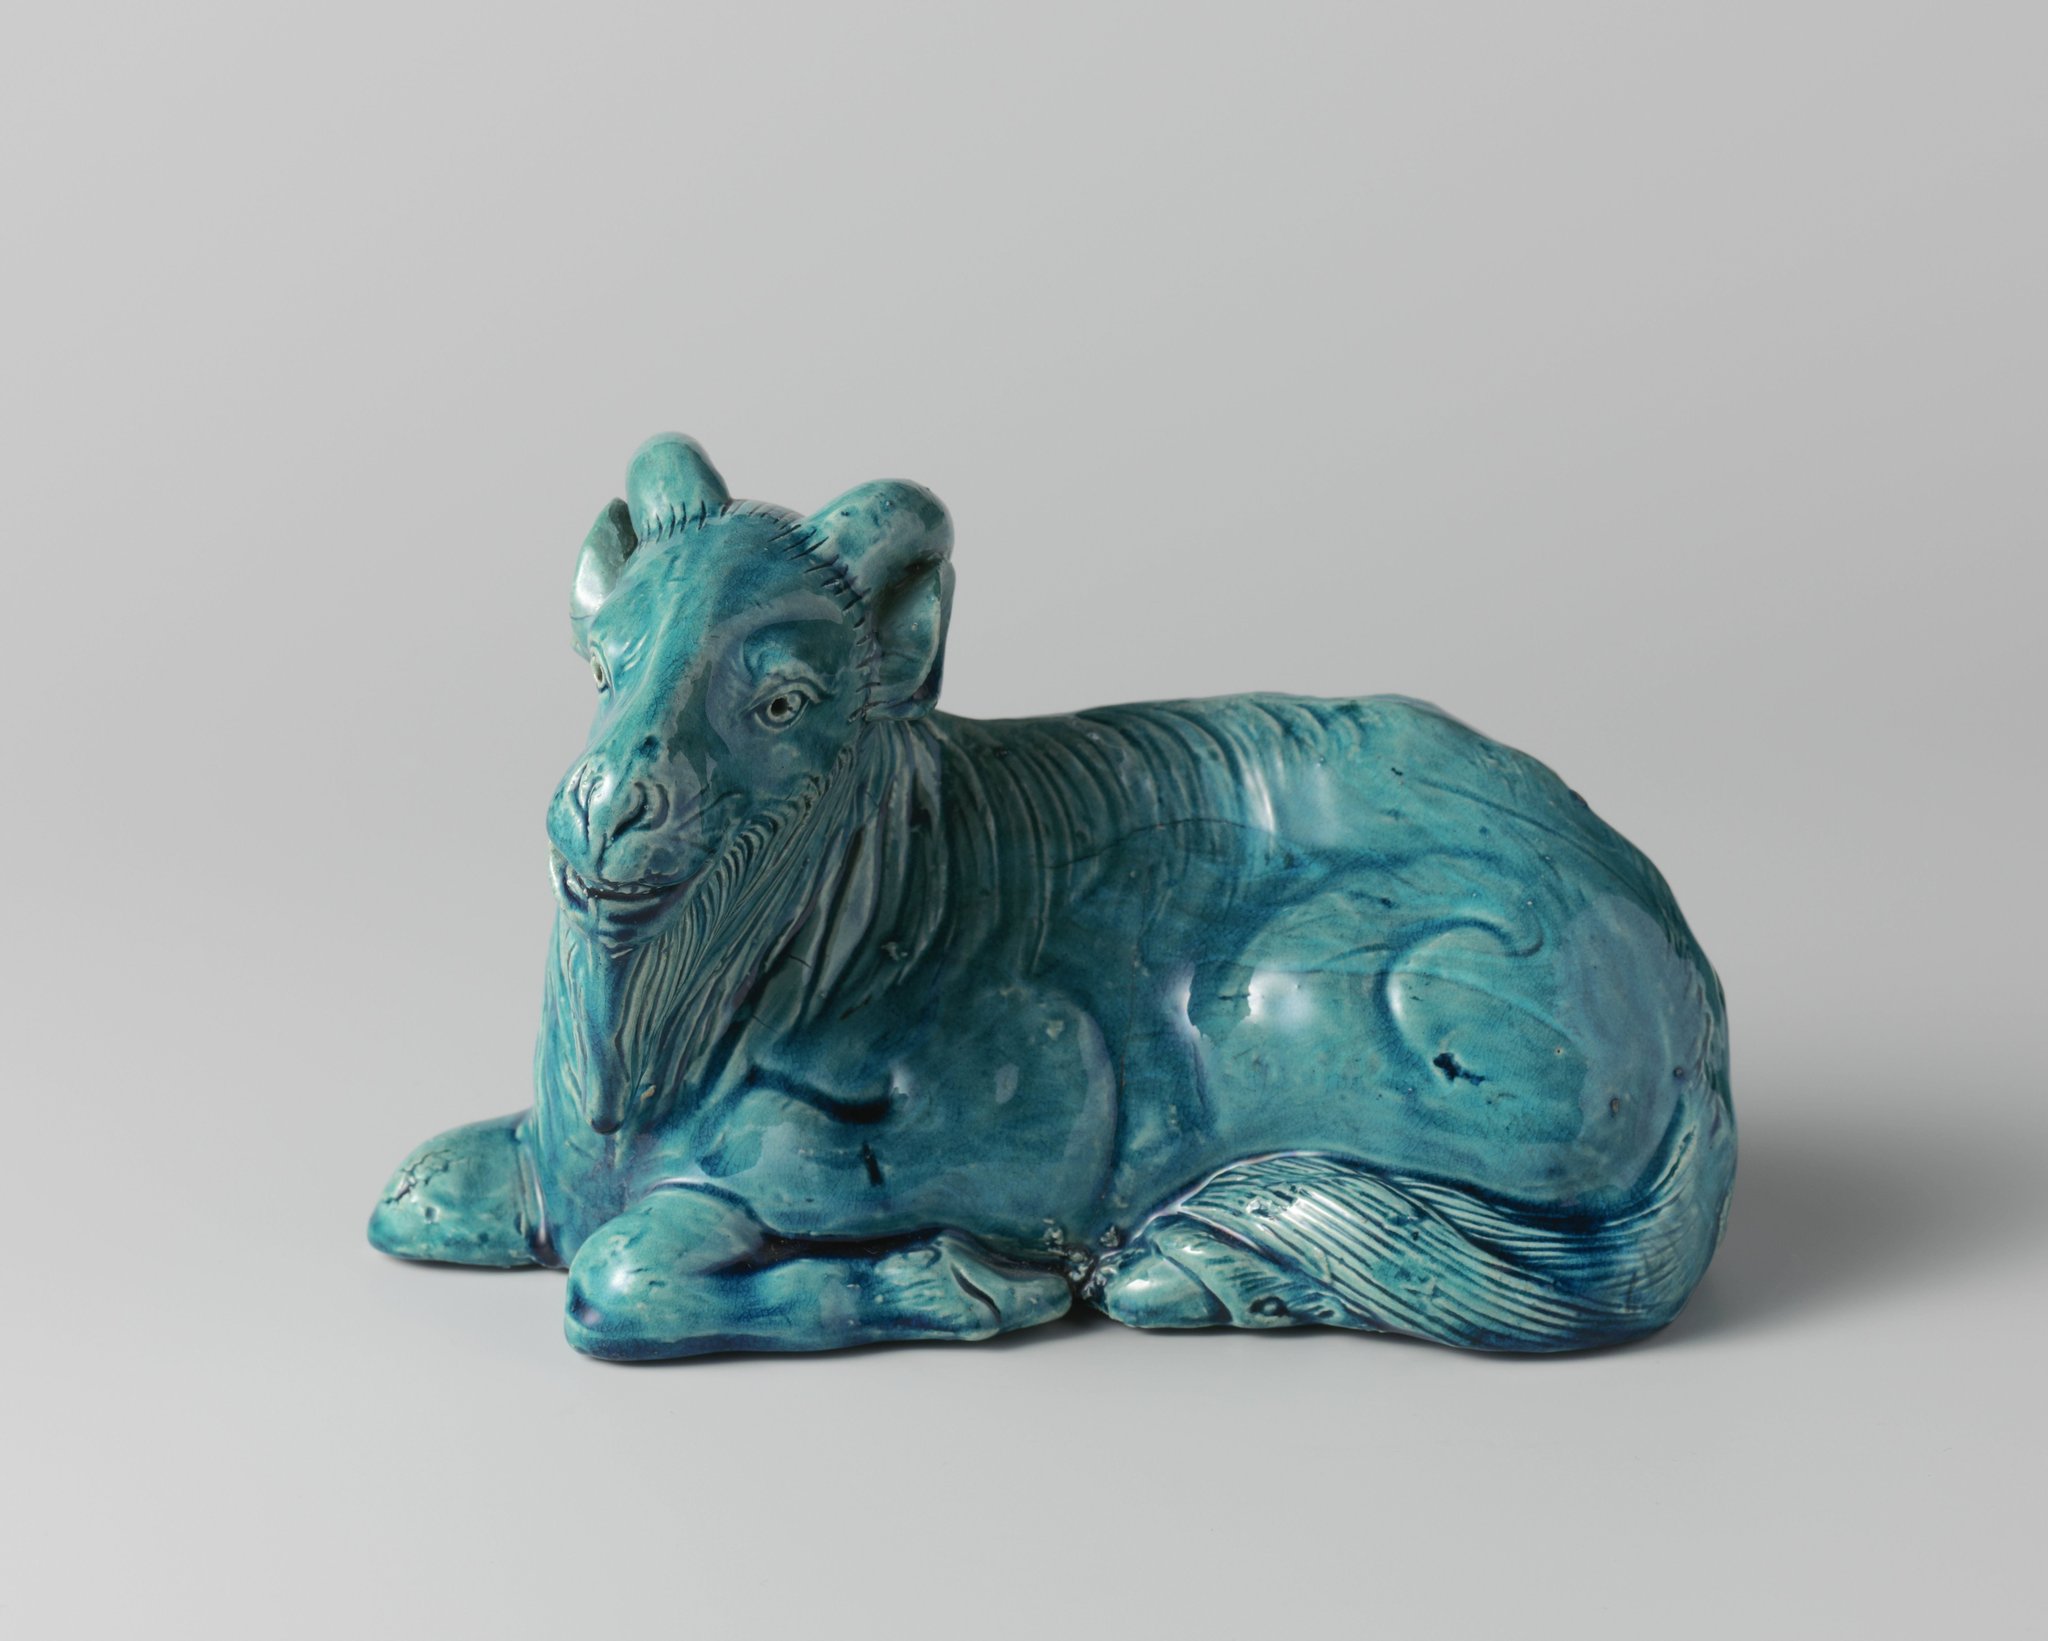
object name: figure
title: Pair of rams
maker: Anonymous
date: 1800-1900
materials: glaze, porcelain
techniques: firing, forming, vitrification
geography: china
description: Beeld van porselein, bedekt met een turquoise glazuur. De liggende ram heeft twee horens, sik en lange manen, het hoofd is naar rechts gedraaid. Beeld is gebroken geweest. Monochromen.